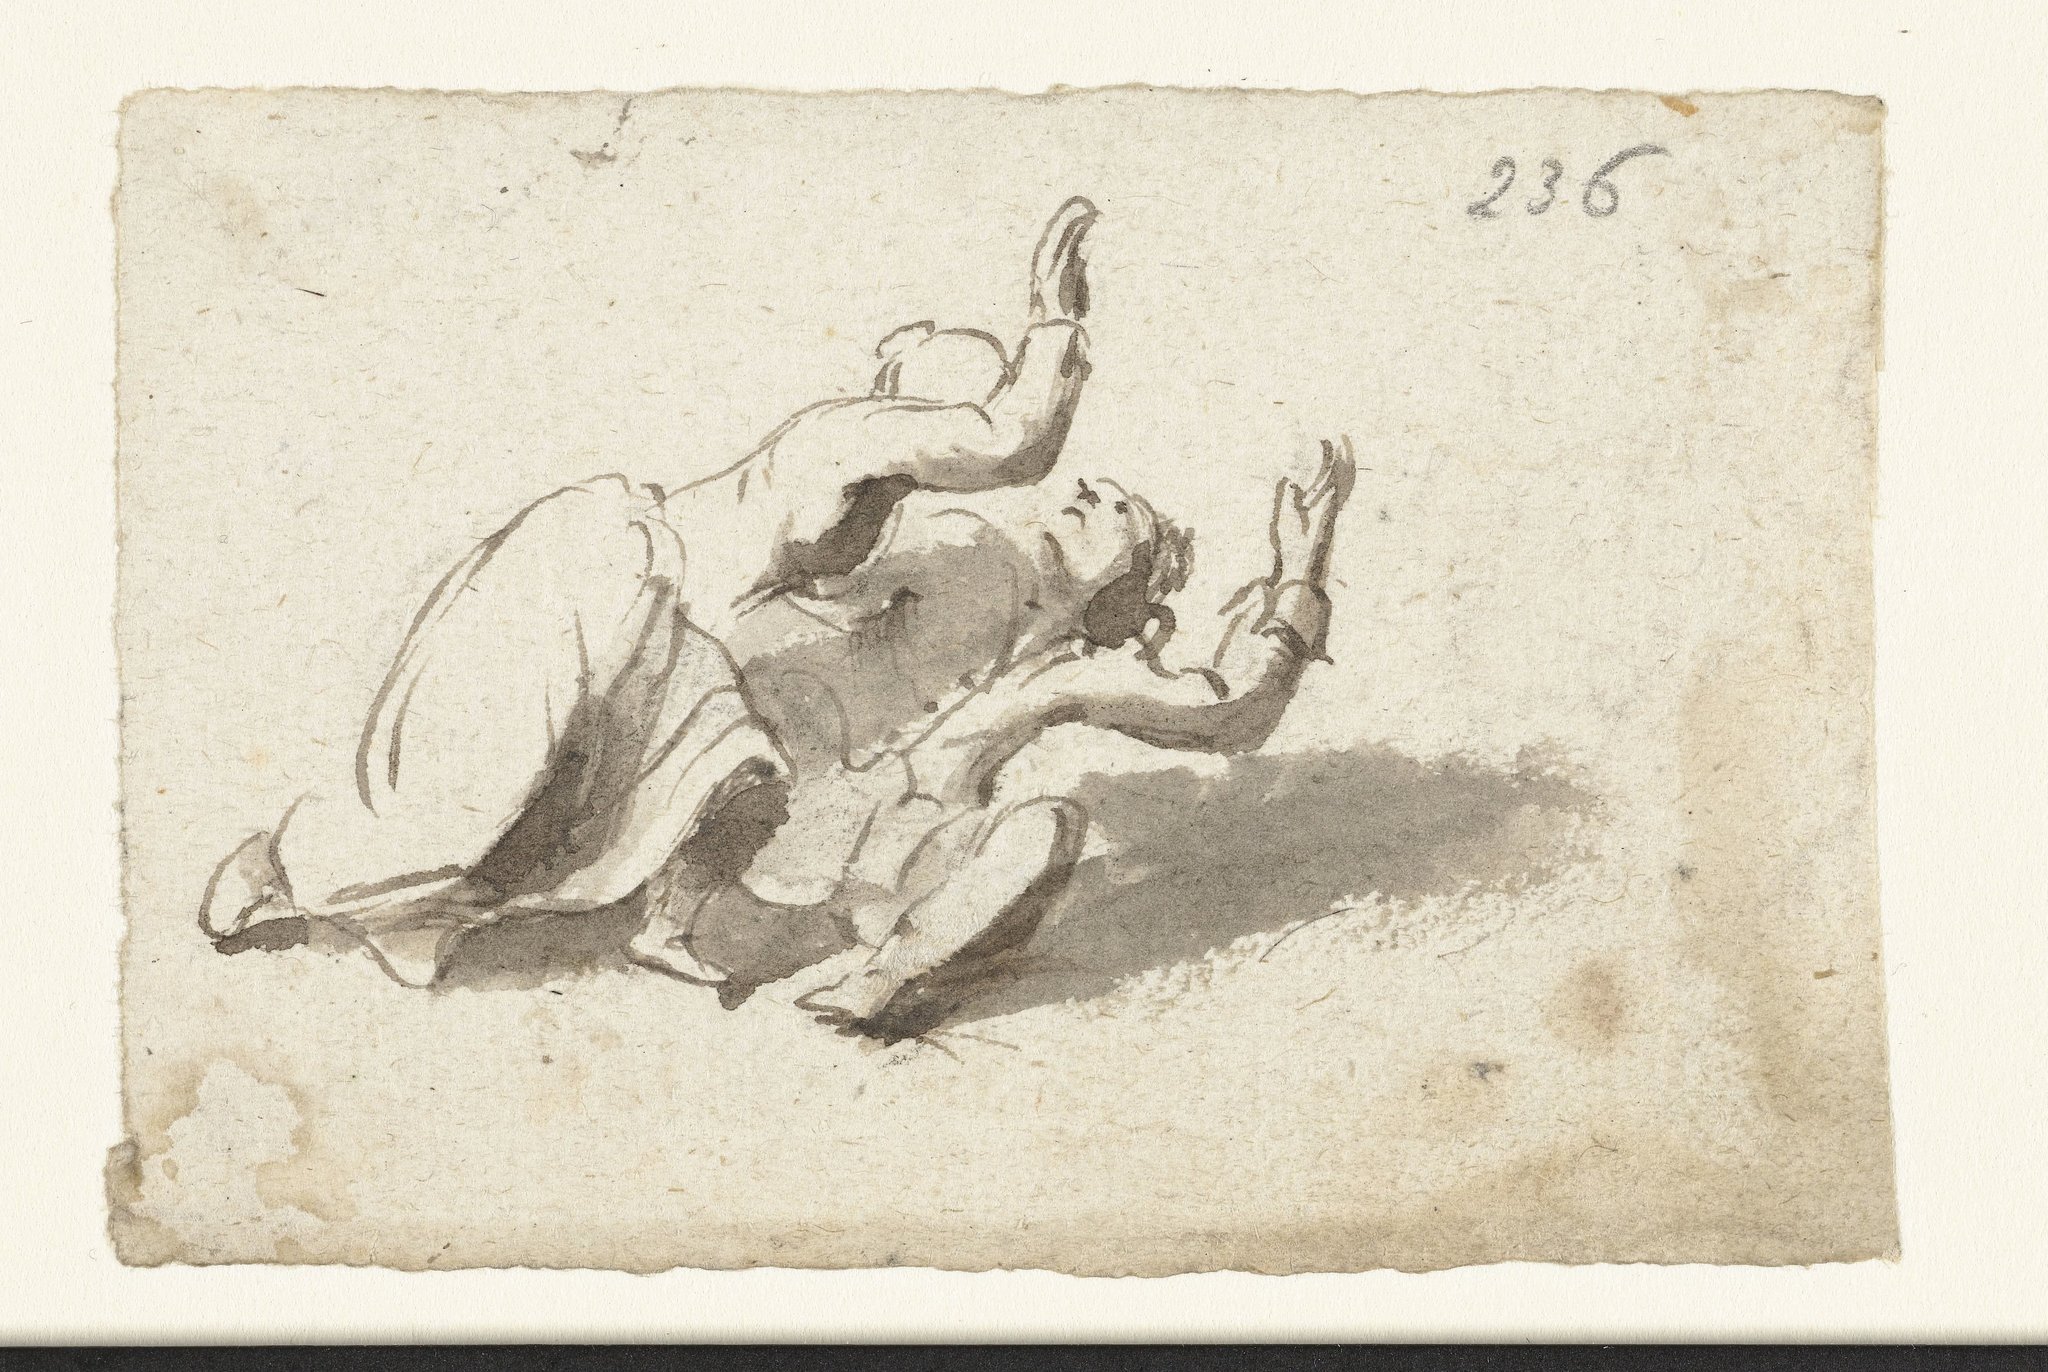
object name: drawing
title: Vechtend stel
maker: harmen ter borch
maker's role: draughtsman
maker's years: 1638-1677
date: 1652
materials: ink, paper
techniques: brush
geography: zwolle